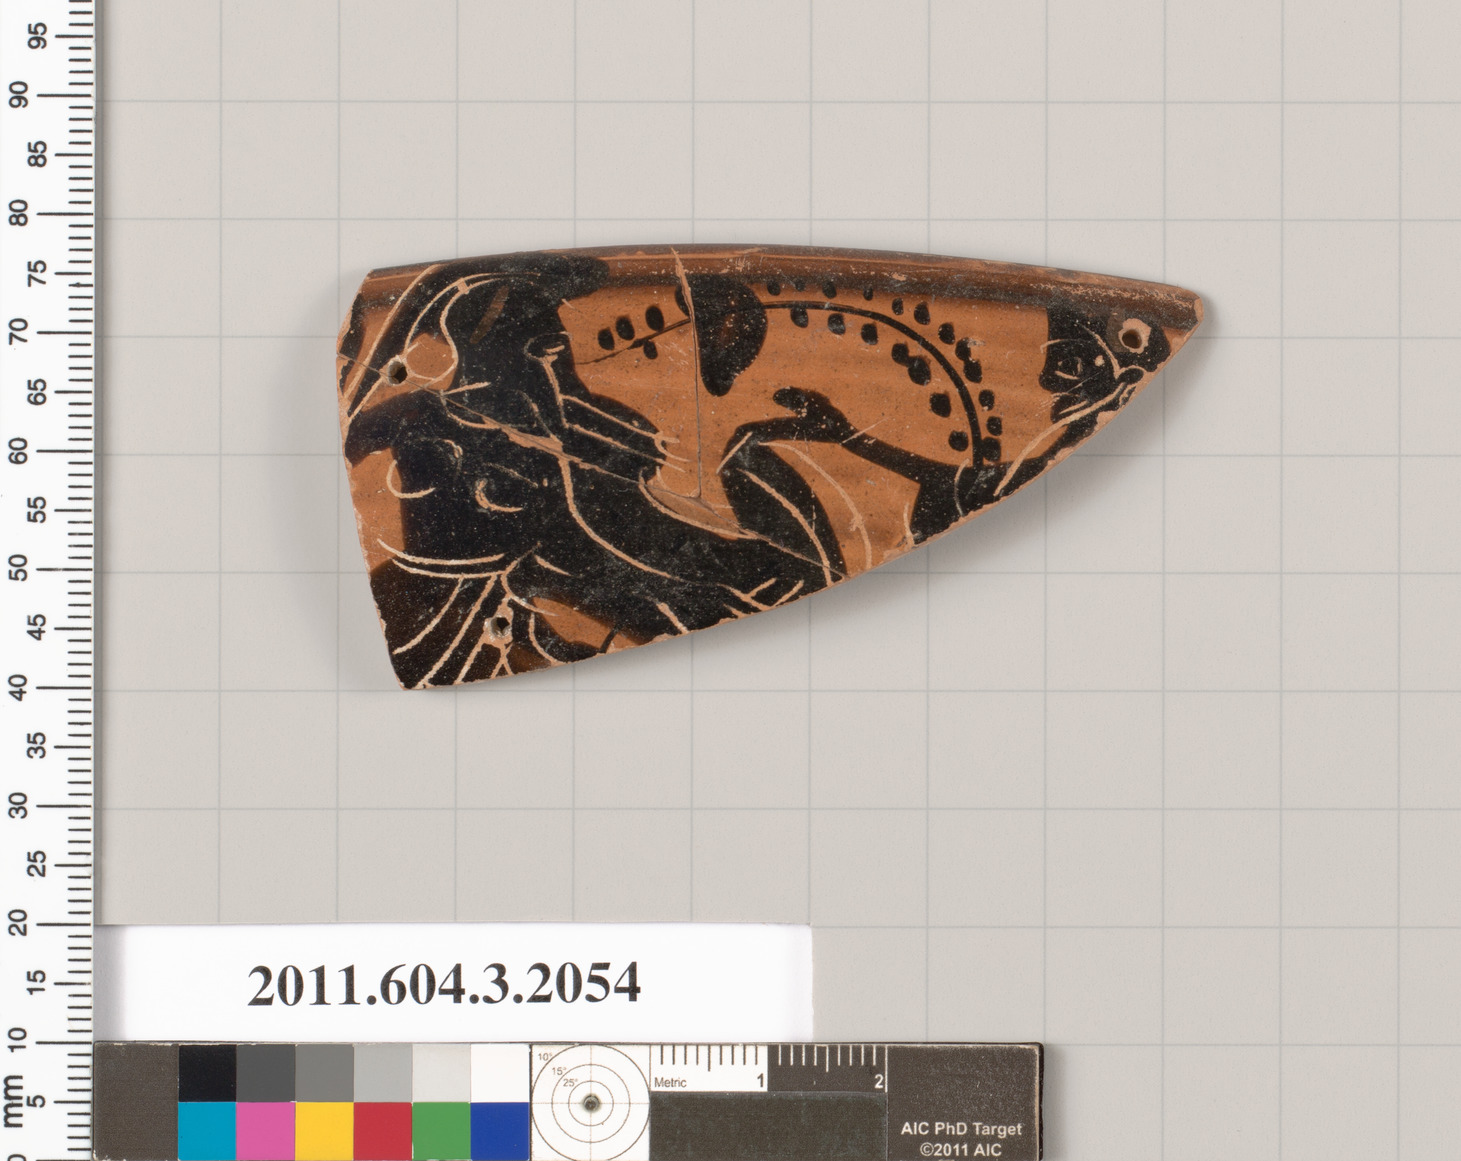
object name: kylix fragment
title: Terracotta rim fragment of a kylix (drinking cup)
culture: greek, attic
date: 500-468 BCE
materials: terracotta